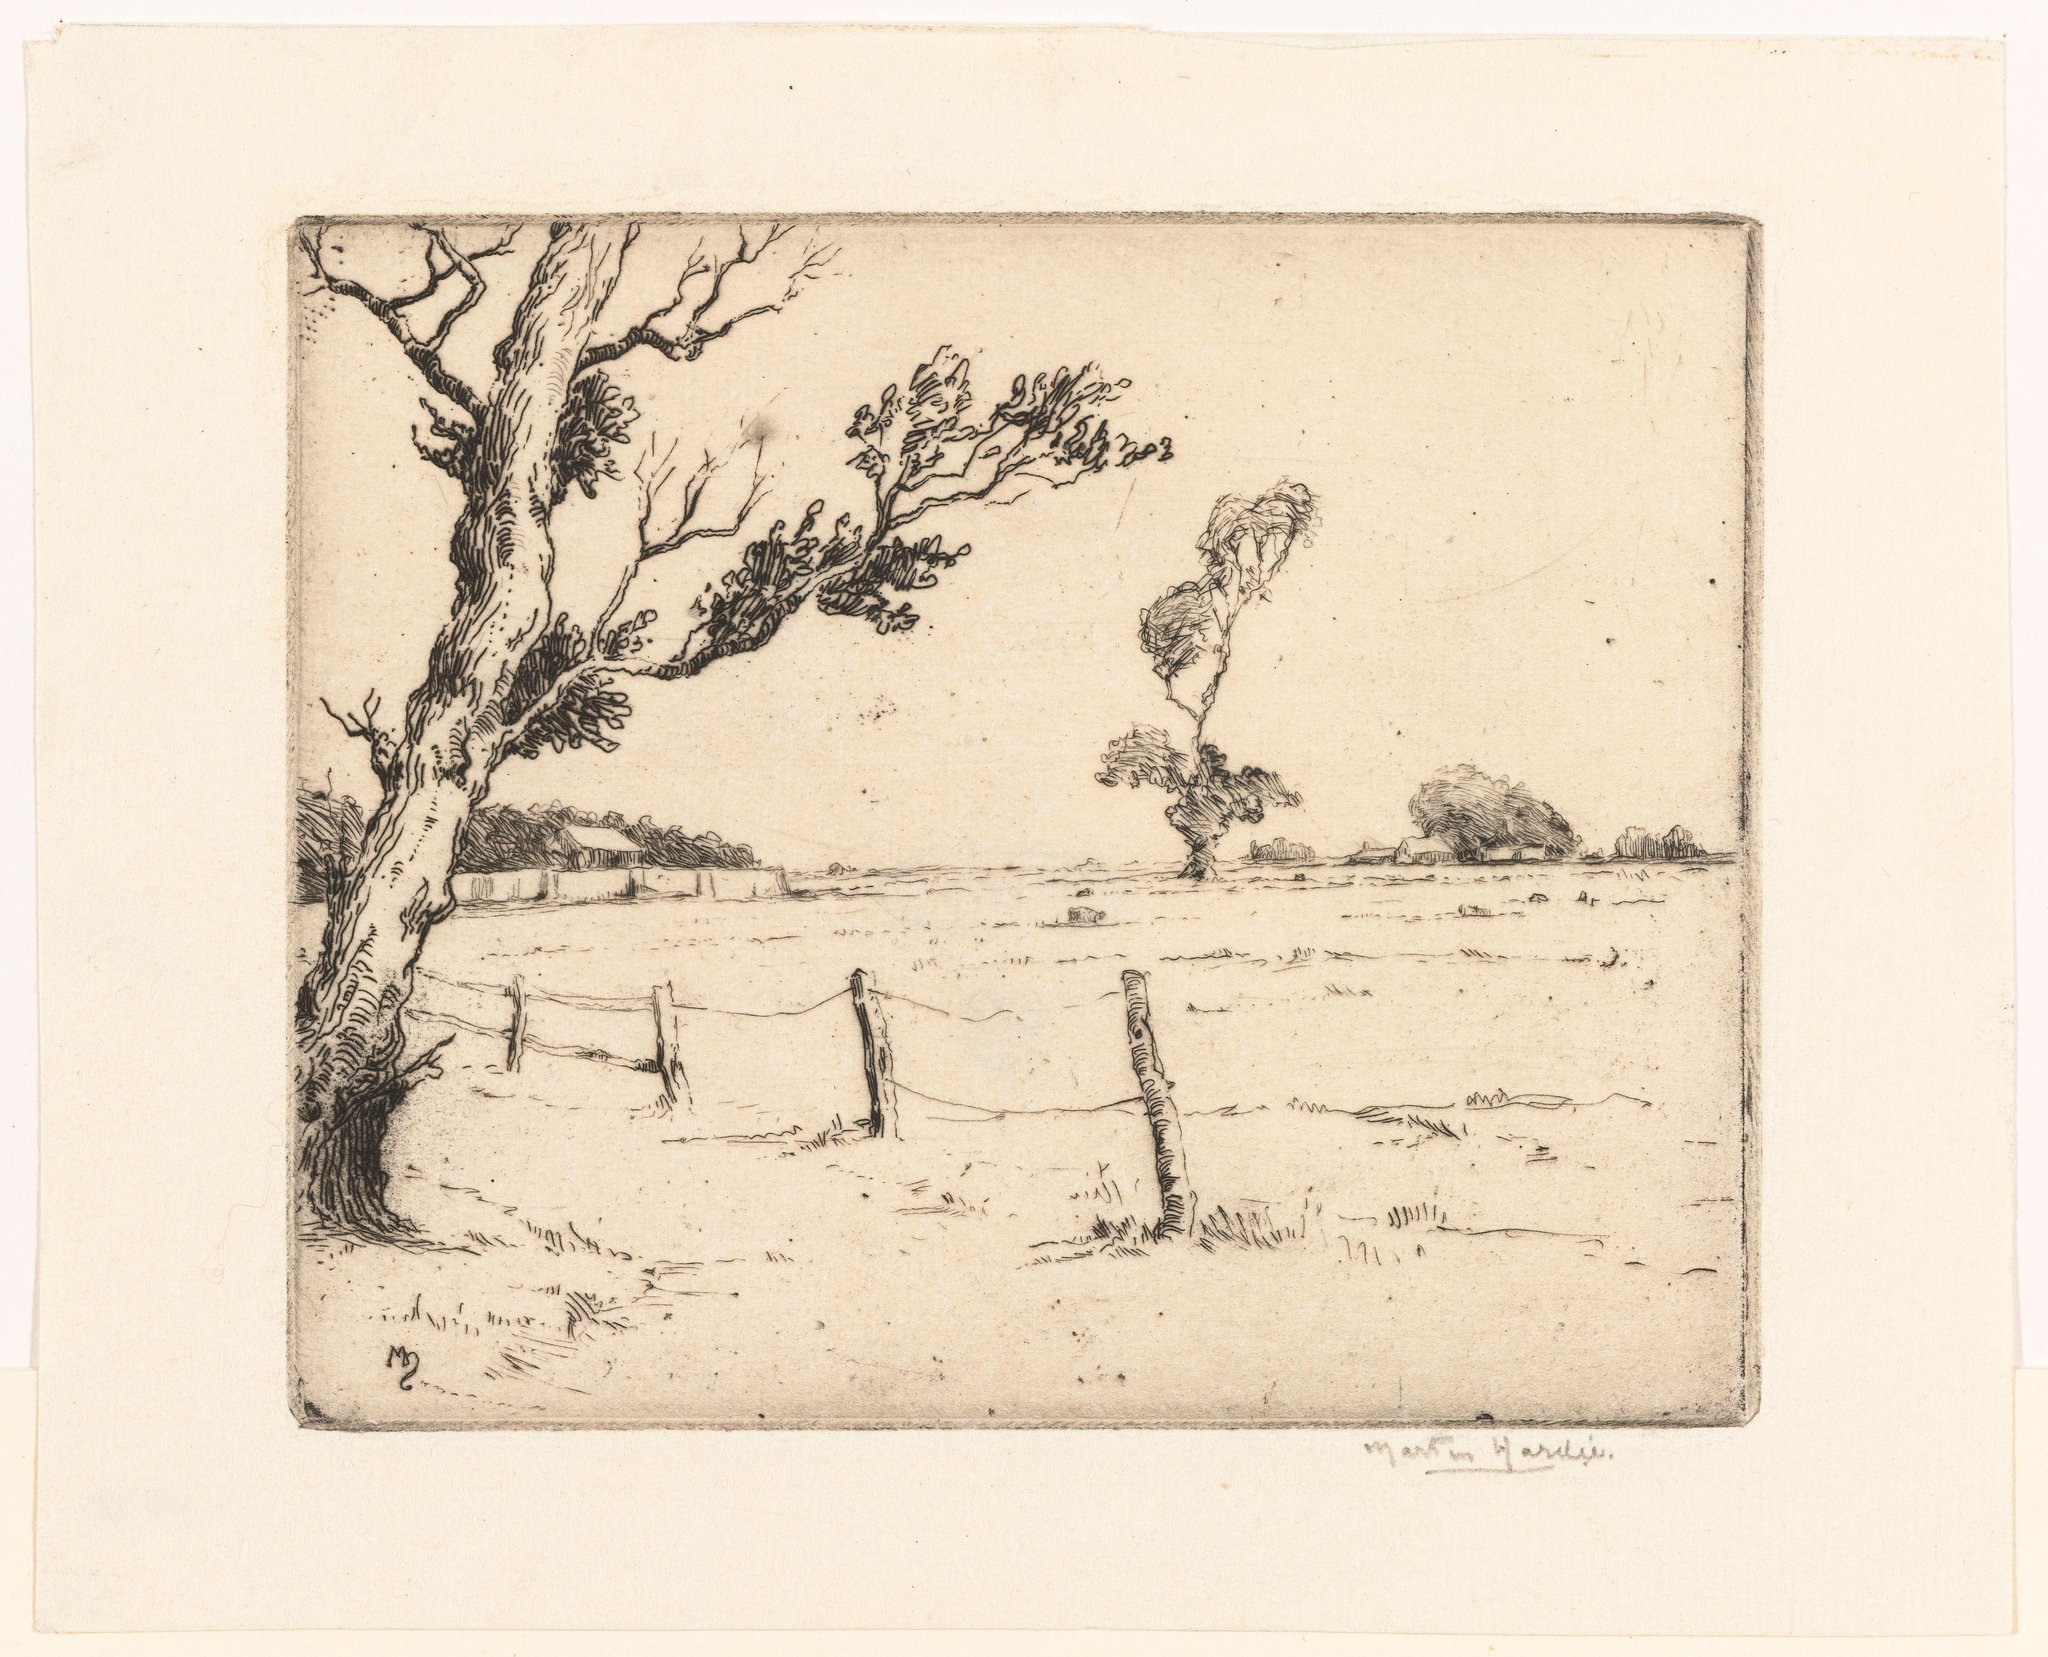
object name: print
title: A Distant View, Wareham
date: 1912-1914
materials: paper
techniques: etching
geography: wareham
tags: meadow, pasture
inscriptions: collector's mark: Lugt 2760, collector's mark: Lugt 2228, annotation: ‘Martin Hardie’